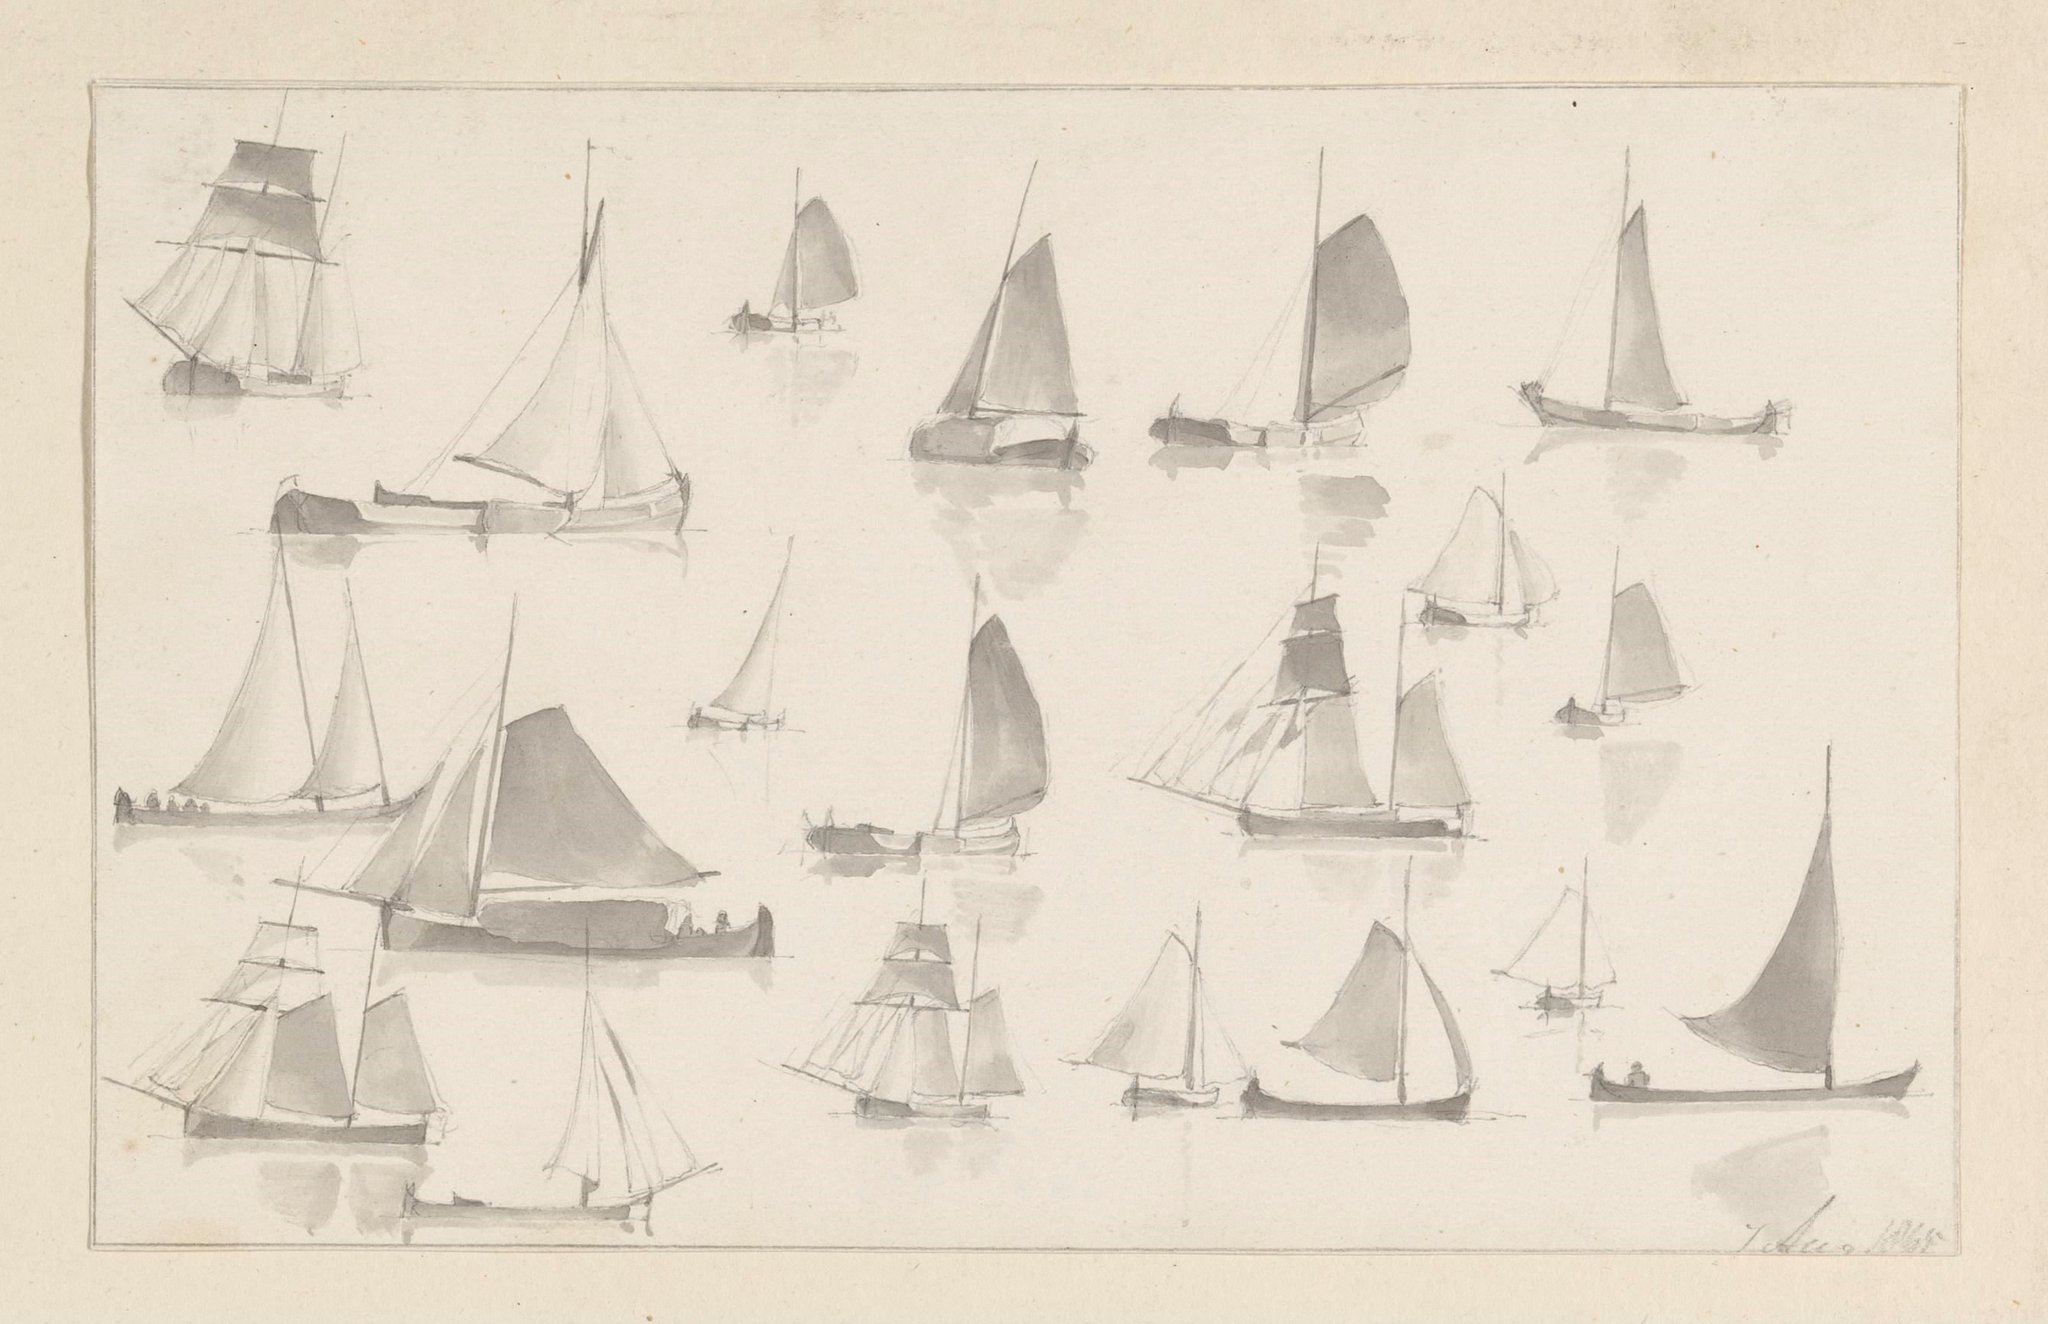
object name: drawing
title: Schetsblad met zeilvaartuigen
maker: hendrik abraham klinkhamer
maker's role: draughtsman, painter, print maker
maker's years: 1810-1872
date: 1845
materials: paper, pencil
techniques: brush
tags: sailing-ship, sailing-boat